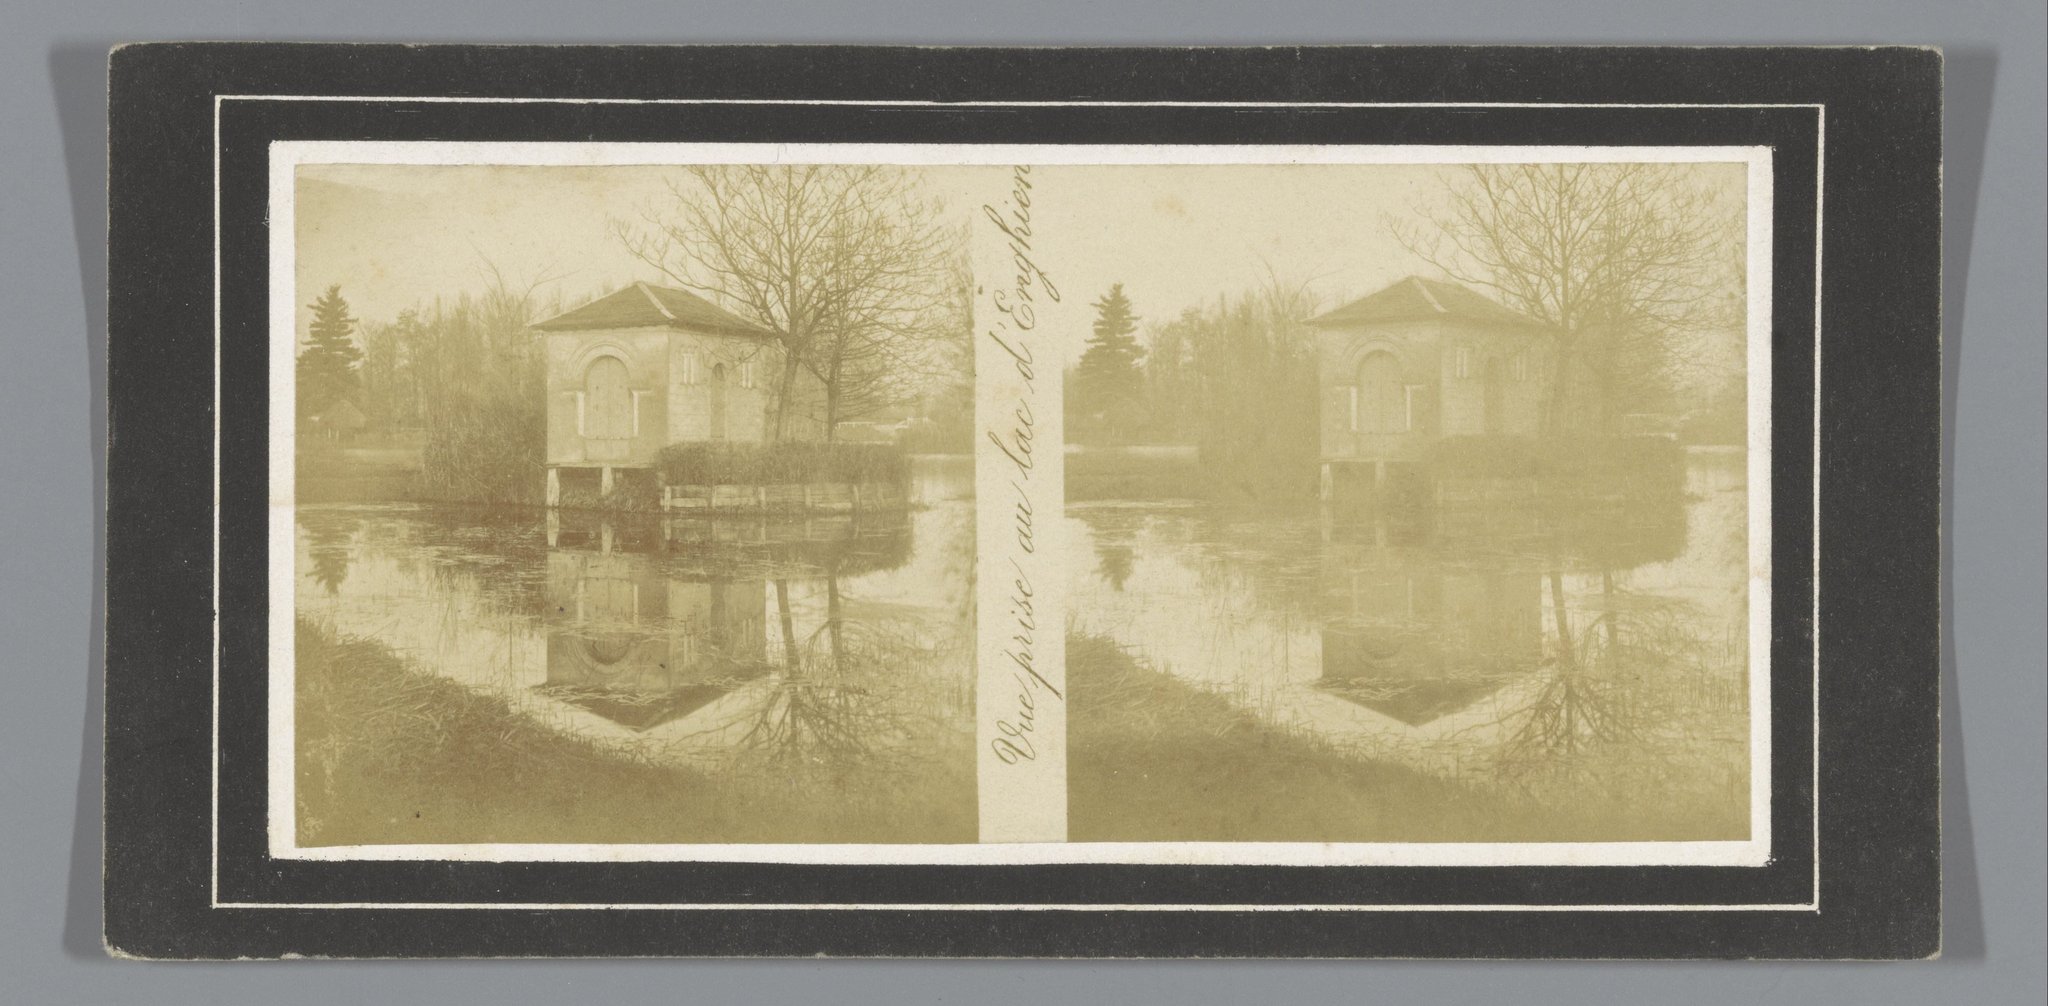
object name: stereograph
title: Vue prise au lac d'Enghien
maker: Anonymous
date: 1860-1880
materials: cardboard, photographic support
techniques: albumen print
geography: paris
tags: lake